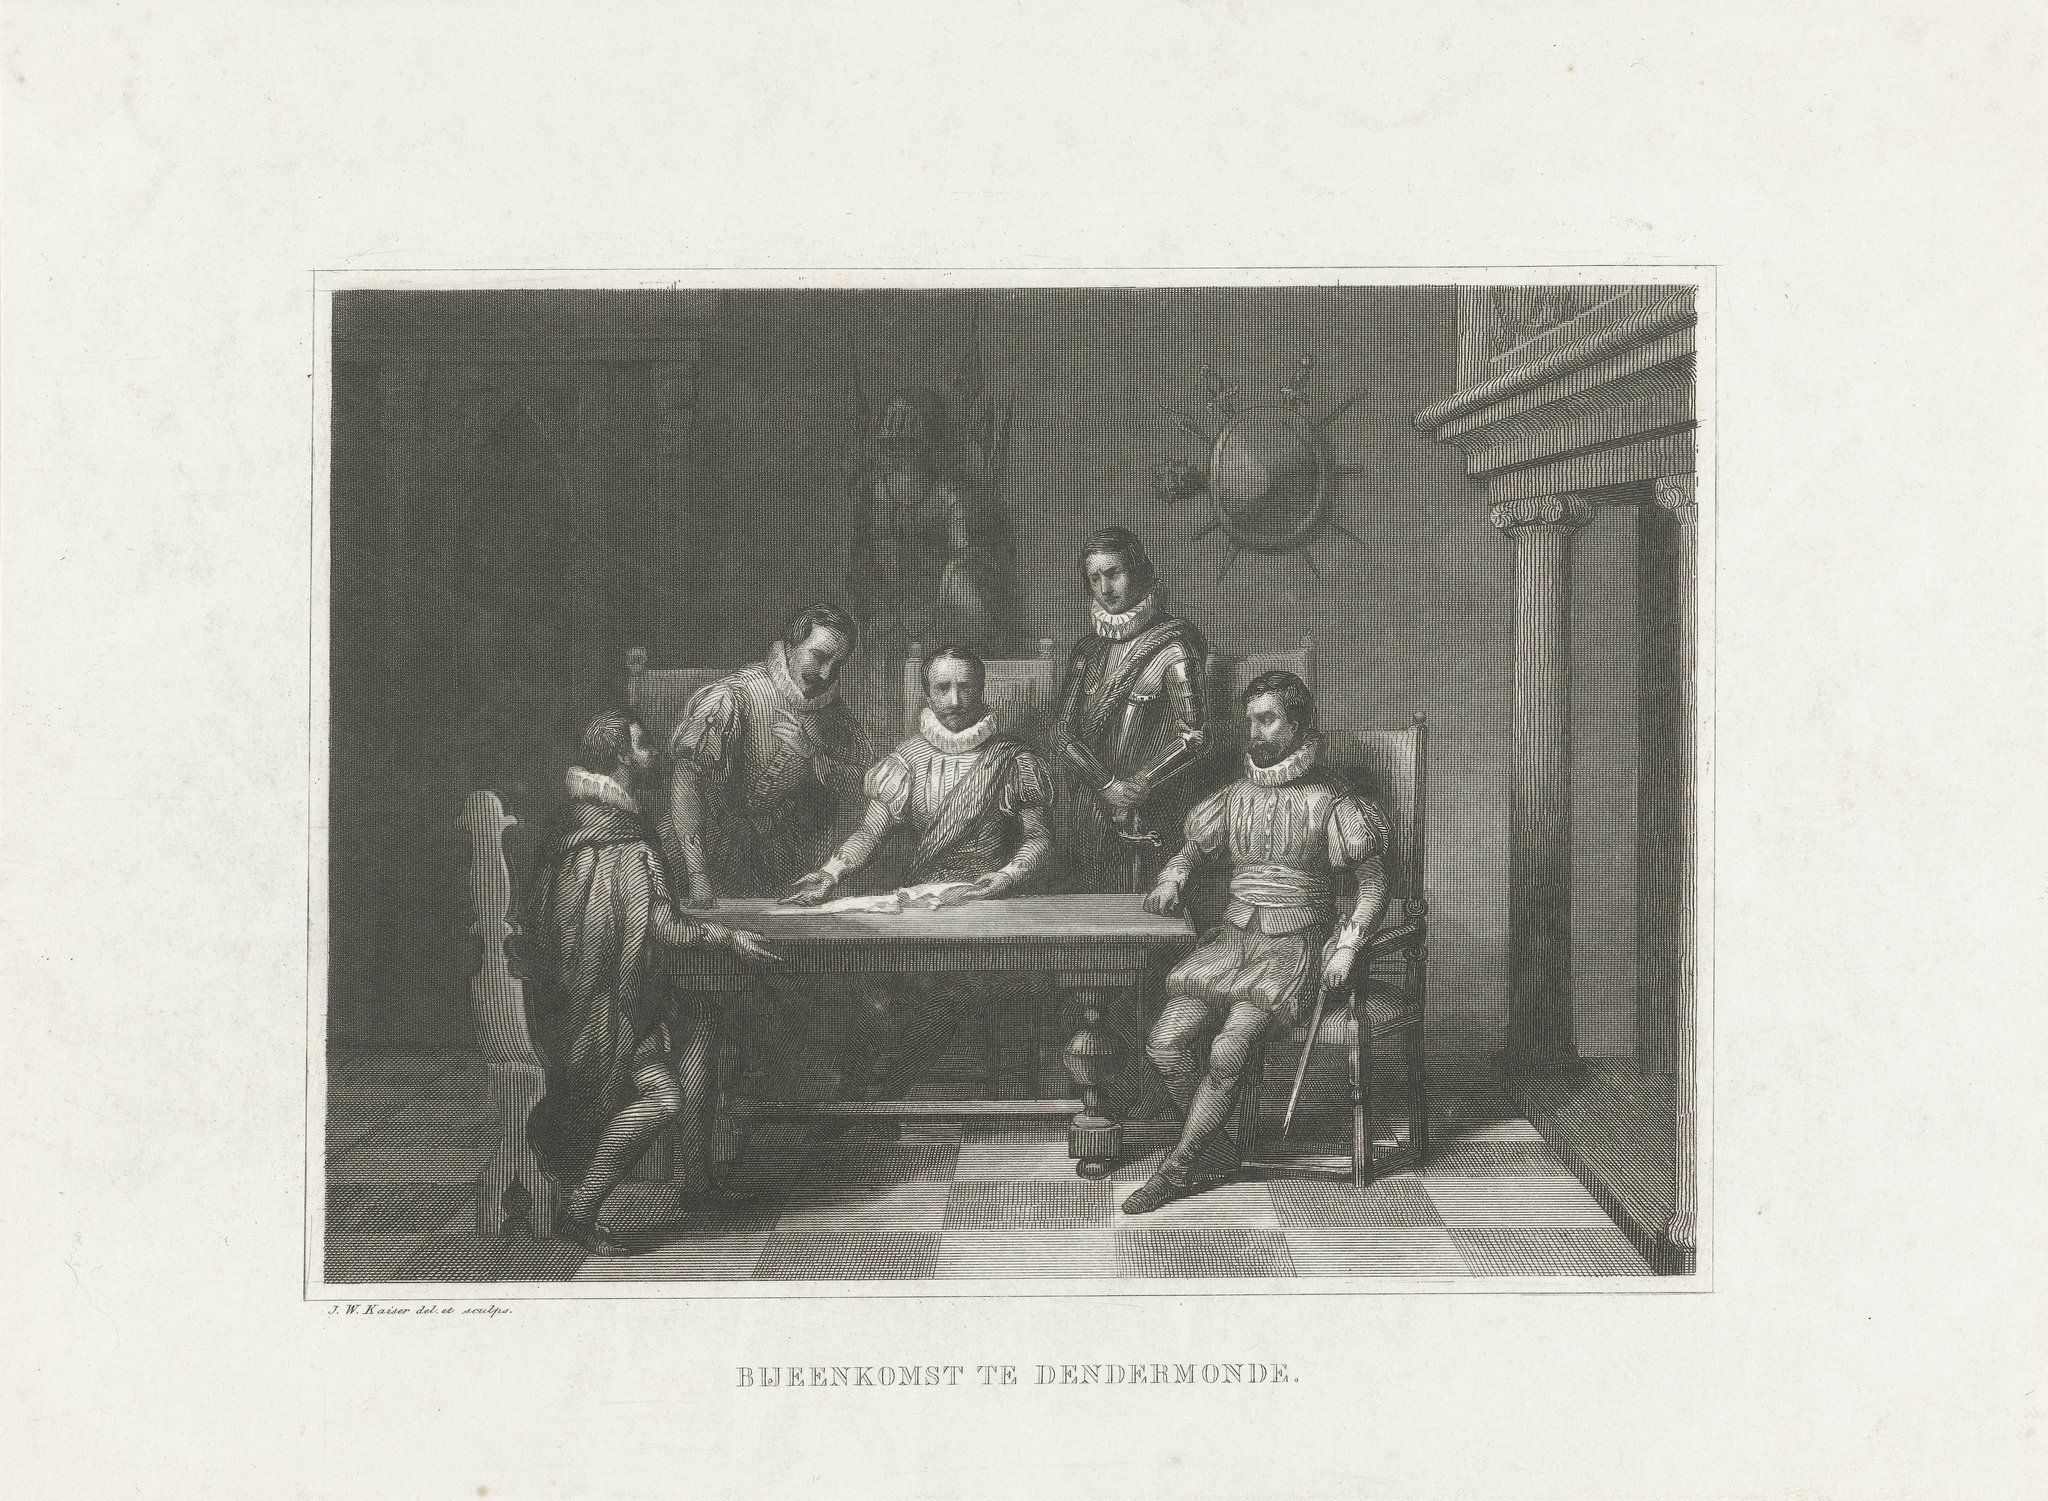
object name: print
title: Bijeenkomst te Dendermonde met Willem van Oranje, 1566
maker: johann wilhelm kaiser (i)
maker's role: draughtsman, print maker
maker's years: 1813-1900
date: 1847-1849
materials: paper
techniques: engraving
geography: netherlands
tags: delft, william i (prince of orange)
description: Bijeenkomst te Dendermonde waarin Willem van Oranje een onderschepte brief van de Spaanse gezant te Parijs ter tafel brengt, 3 oktober 1566. Interieur met vijf mannen rond een tafel.